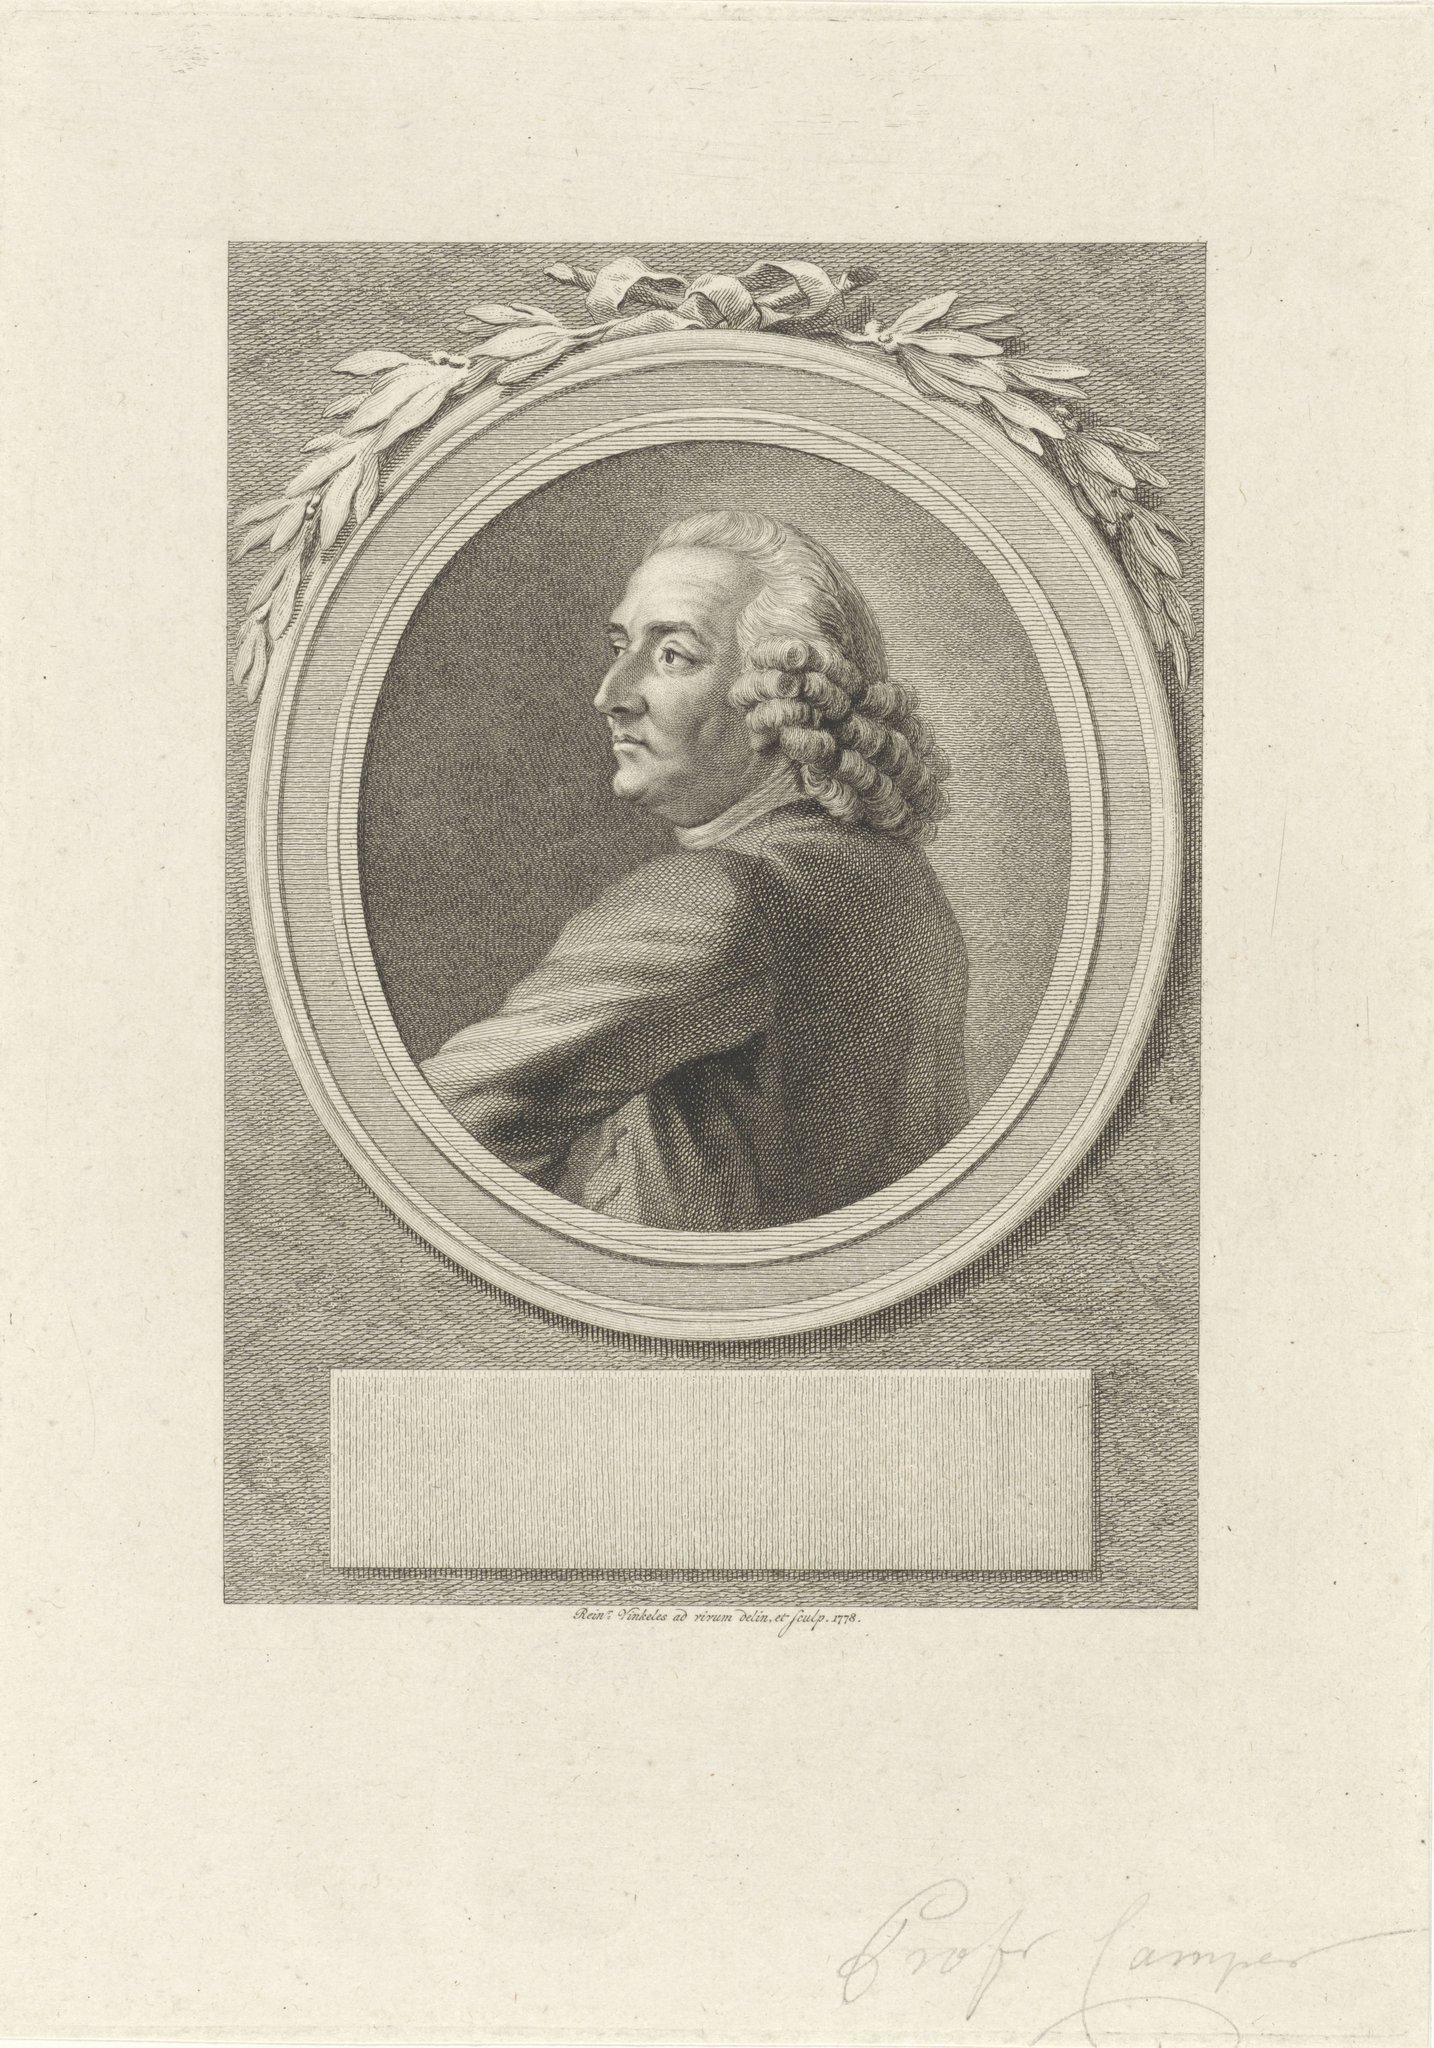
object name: print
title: Portret van Petrus Camper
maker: reinier vinkeles (i)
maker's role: draughtsman, print maker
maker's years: 1741-1816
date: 1778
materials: paper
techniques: engraving, etching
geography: amsterdam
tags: leiden, the hague, print maker, draughtsman, petrus camper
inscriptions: collector's mark: Lugt 2228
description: Portret van Petrus Camper, tekenaar en medicus, in een ovaal medaillon.